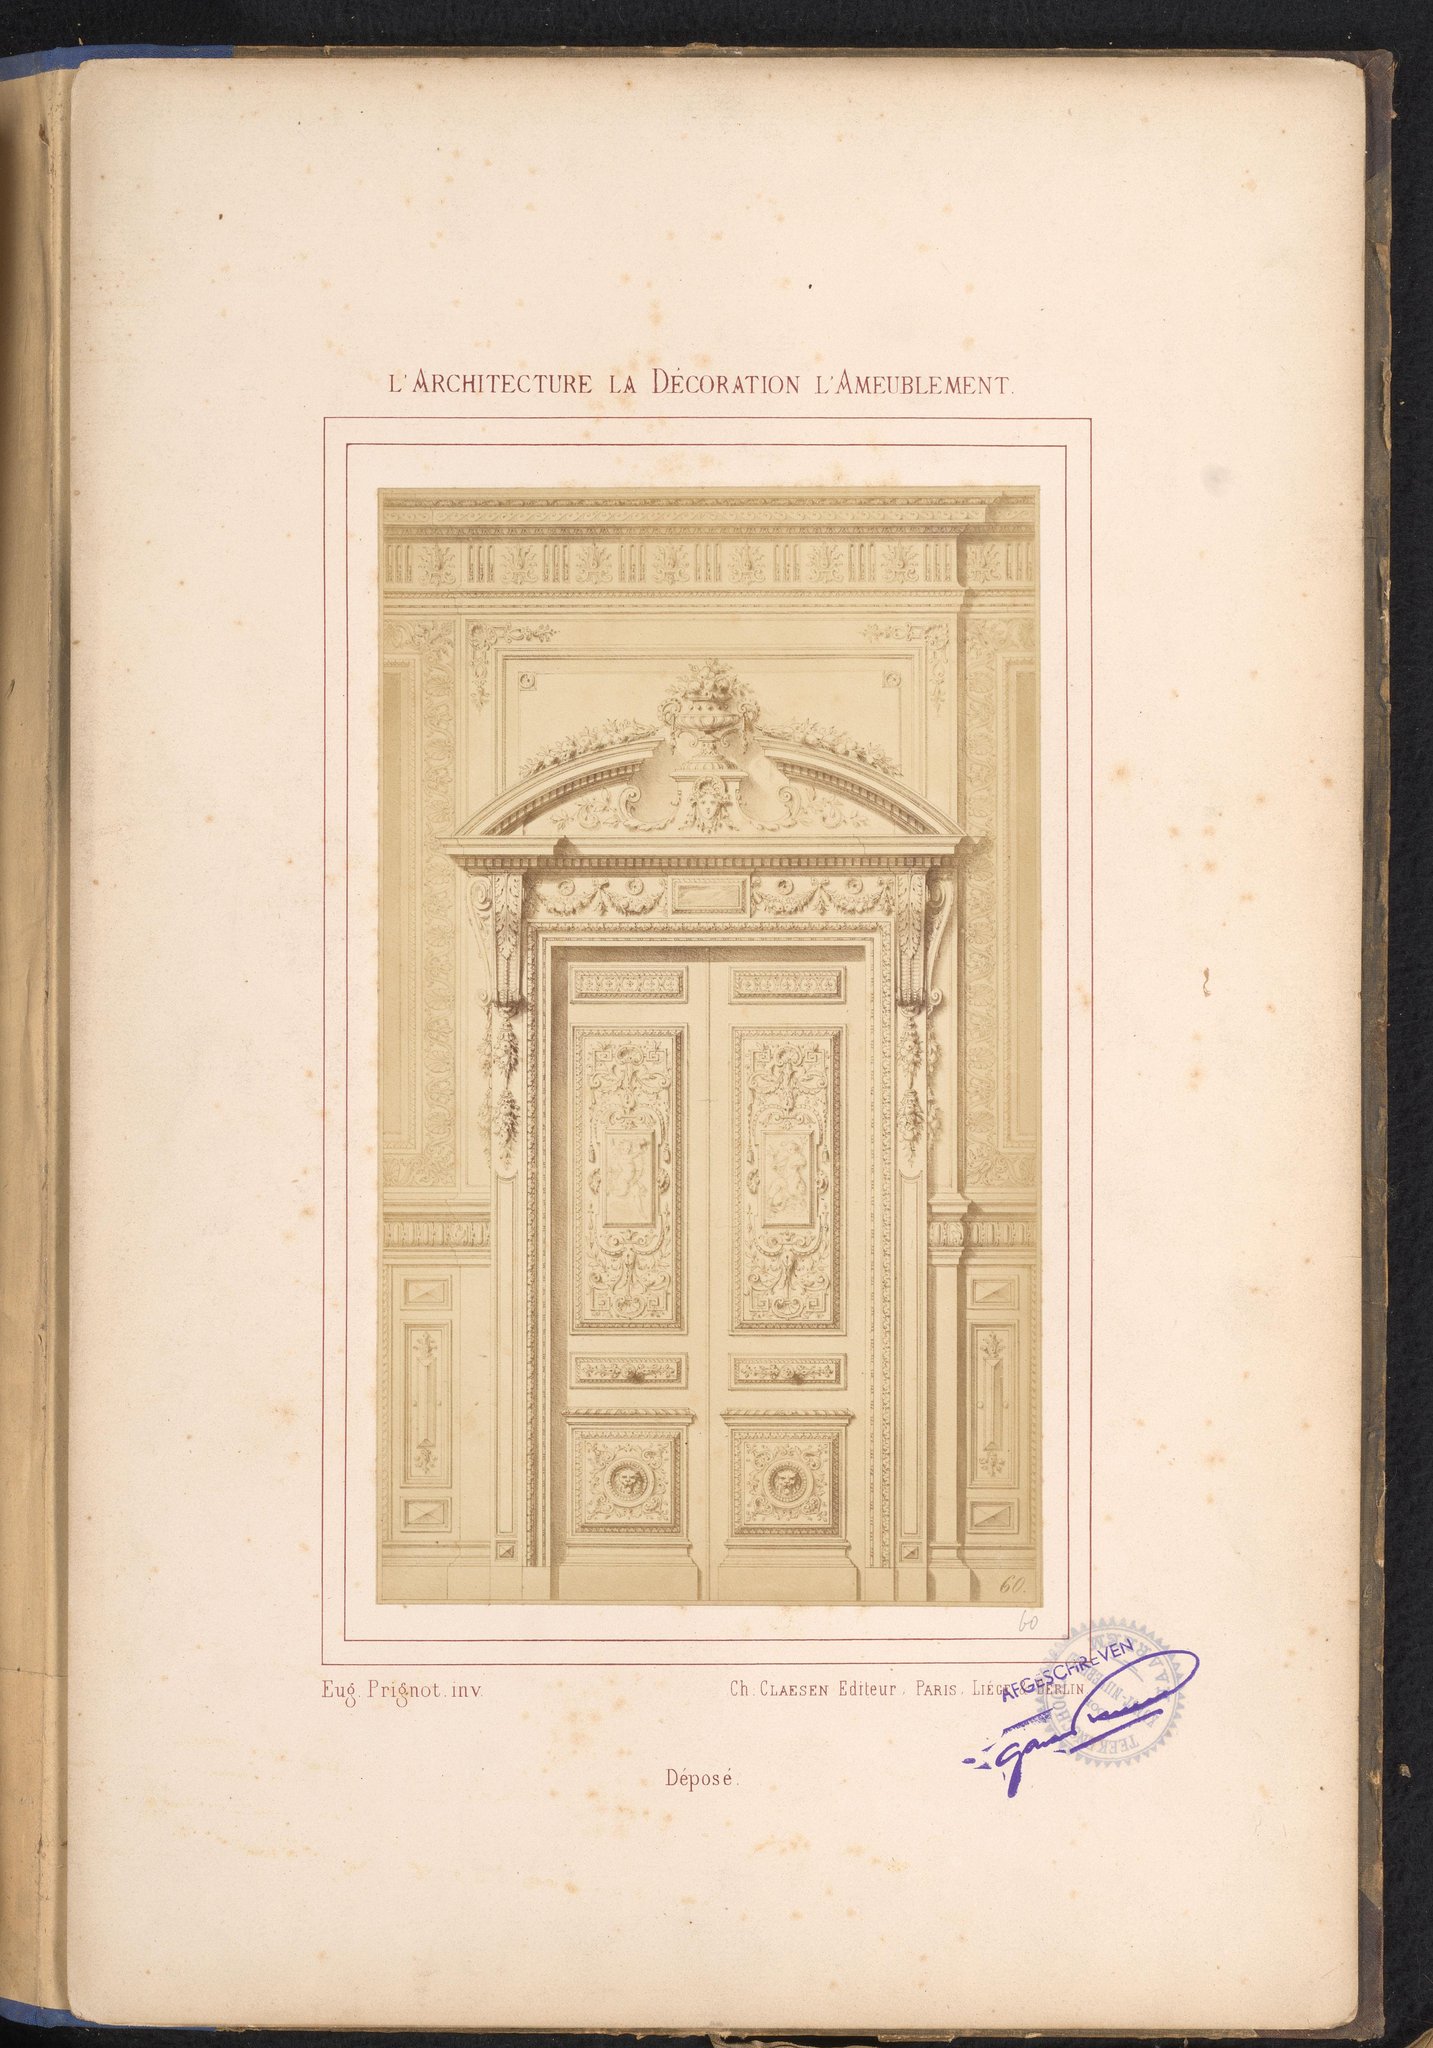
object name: photograph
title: Fotoreproductie van een ontwerp voor een deur naar Alexandre Eugène Prignot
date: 1873-1880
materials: cardboard, paper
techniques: albumen print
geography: liège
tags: door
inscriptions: stamp: ‘AFGESCHREVEN/ [...]’, inscription: ‘Eug. Prignot. inv.’, stamp: ‘TEEKENSCHOOL/ VOOR/ KUNST-NIJVERHEID/ HAARLEM’, number: ‘60’, inscription: ‘Déposé’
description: Deze foto maakt deel uit van een omslag met 61 foto's op 61 bladen.